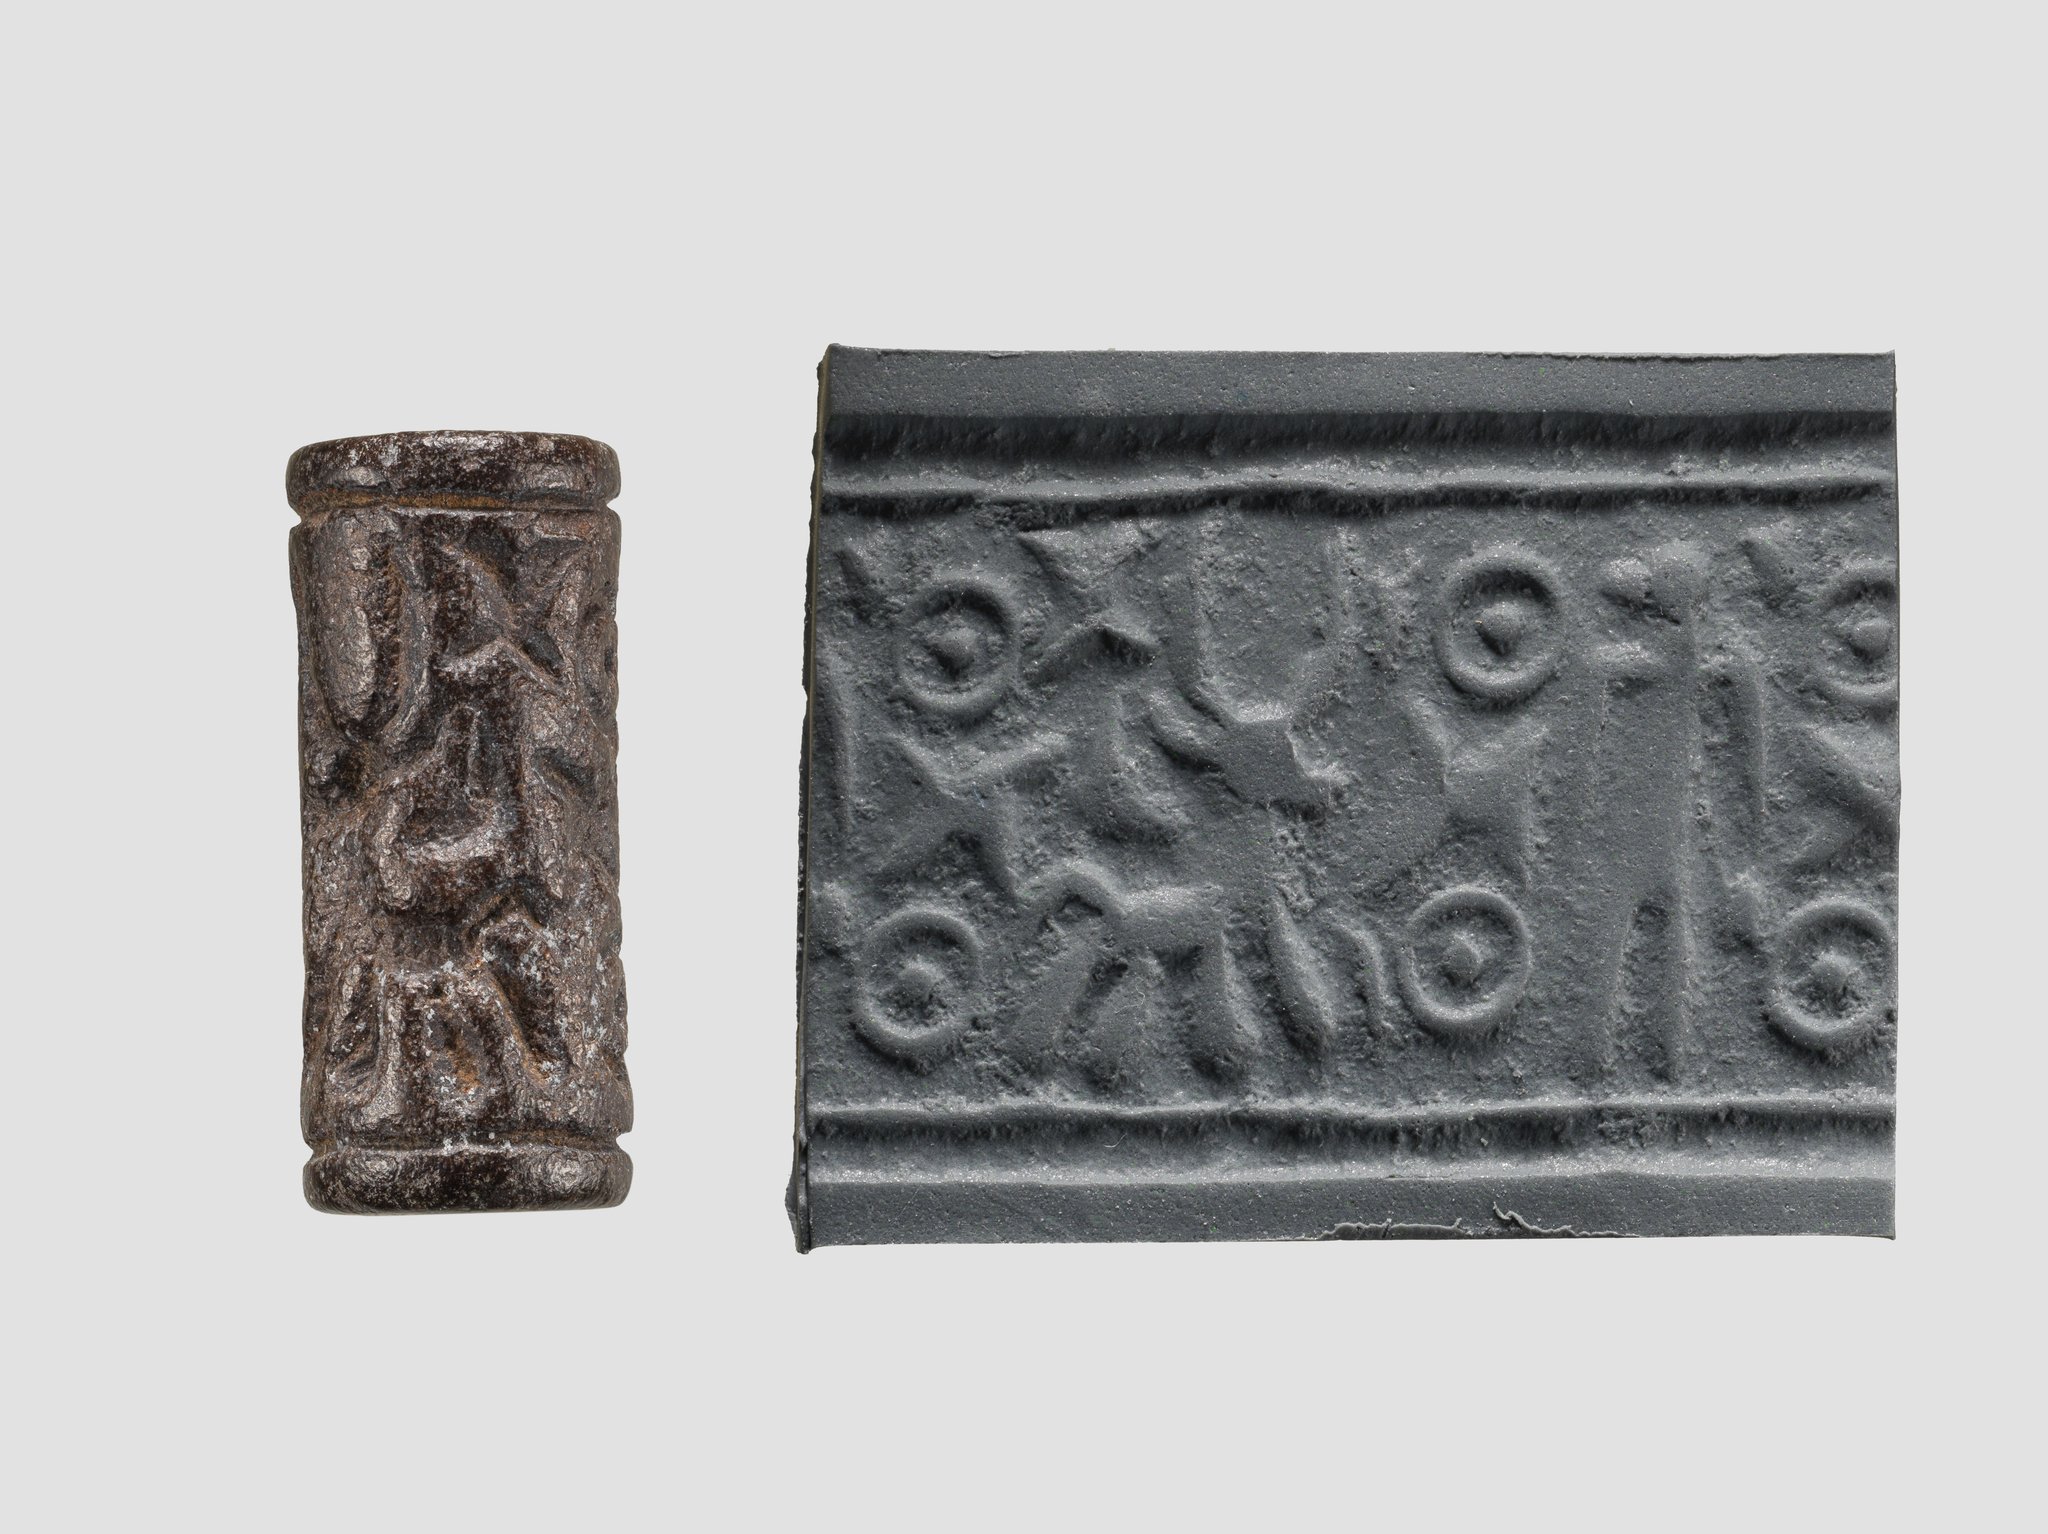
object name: cylinder seal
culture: cypriot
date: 1500-1101 BCE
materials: stone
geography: cyprus